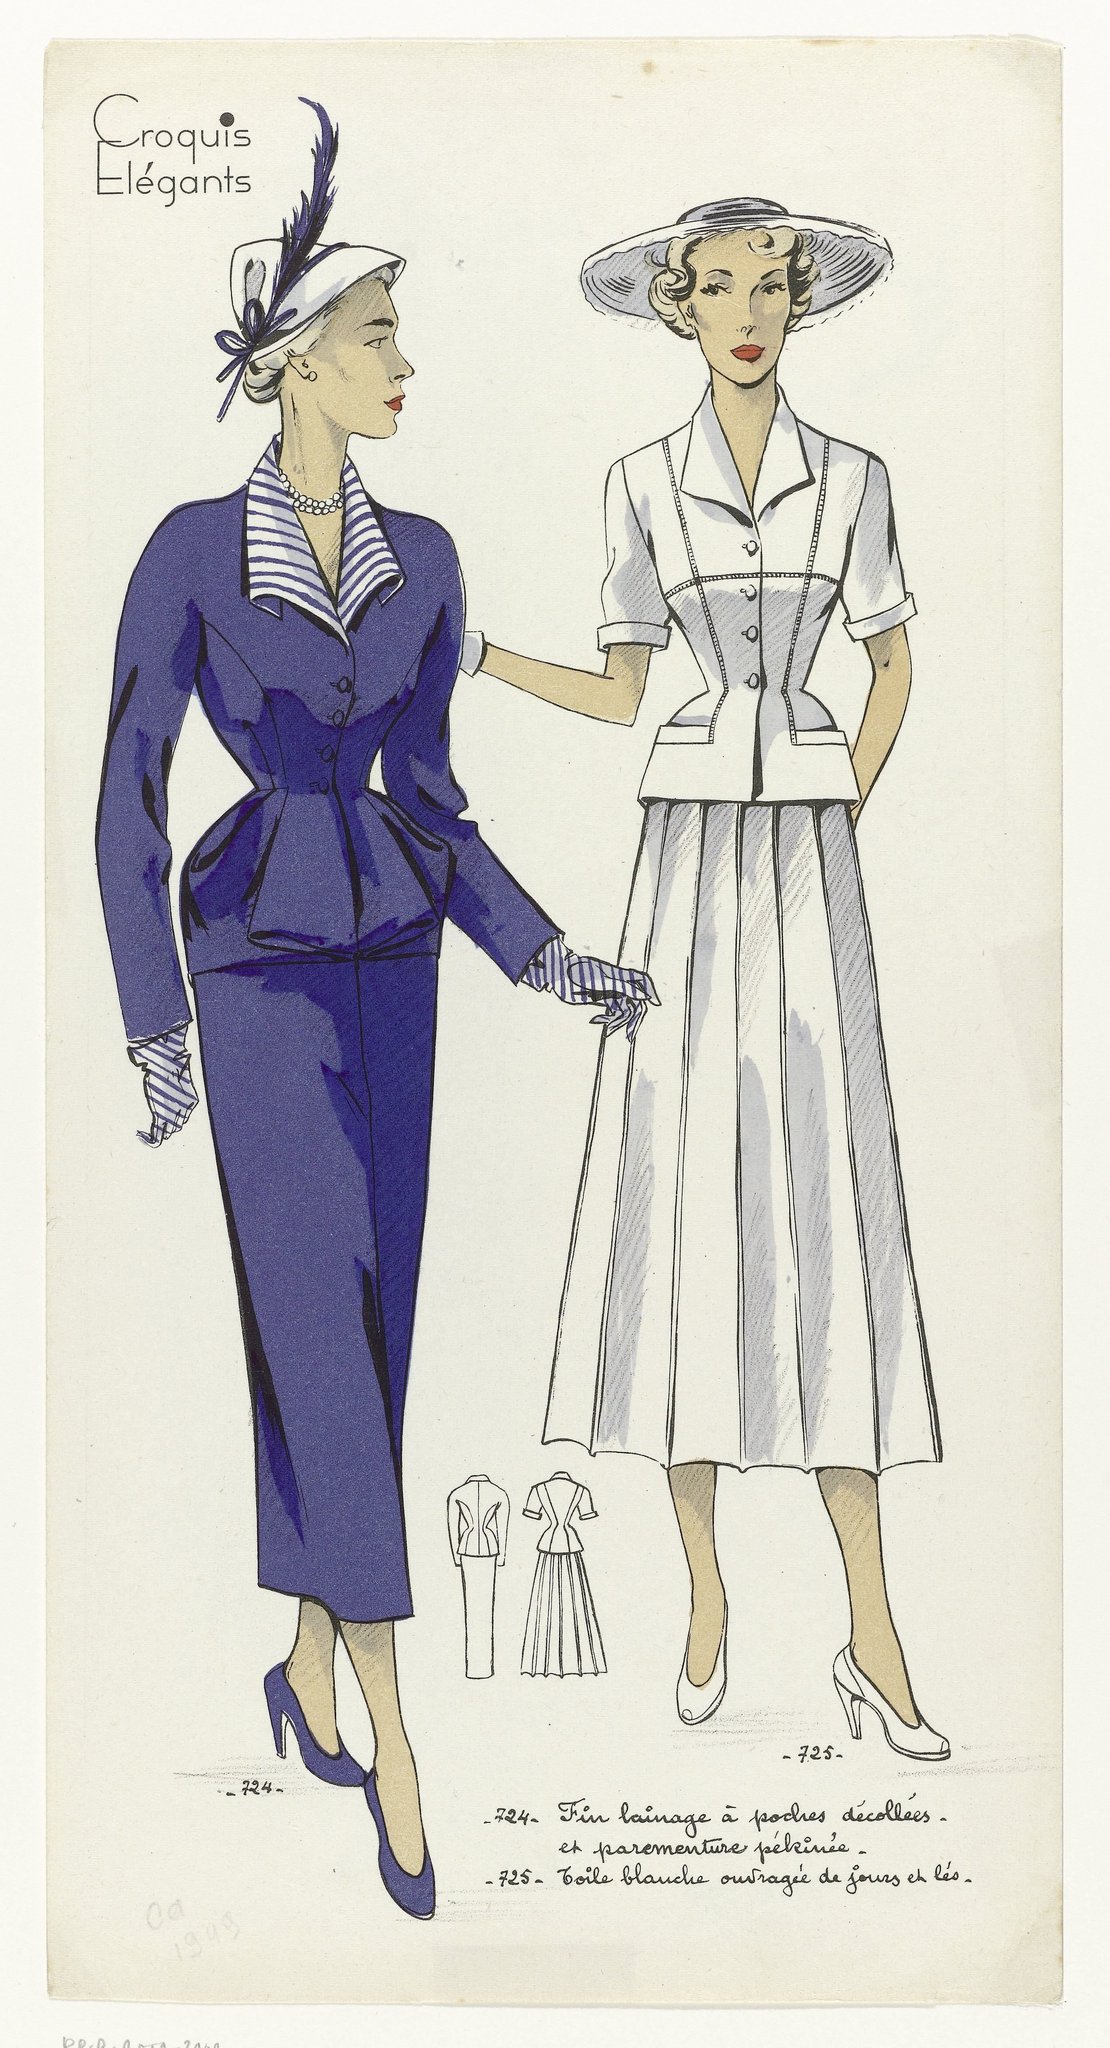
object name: fashion print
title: Croquis Elégants, ca. 1949, No. 724 en No. 725 : Fin lainage à poches (...)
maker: Anonymous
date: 1949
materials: paper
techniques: hand coloring, lithograph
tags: clothing for the upper part of the body (+ women's clothes), head-gear (+ women's clothes), fashion plates, skirt (+ women's clothes), gloves, mittens, etc. (+ women's clothes), necklace (+ women's clothes)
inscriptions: title: ‘Croquis Elégants’, caption: ‘724 Fin lainage à poches décollées - et parementure pékinée. / 725 Toile blanche ouvragée de jours et lés’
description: Twee ensembles eind jaren veertig. Prent uit het modetijdschrift Croquis Elégants (1931-...?).